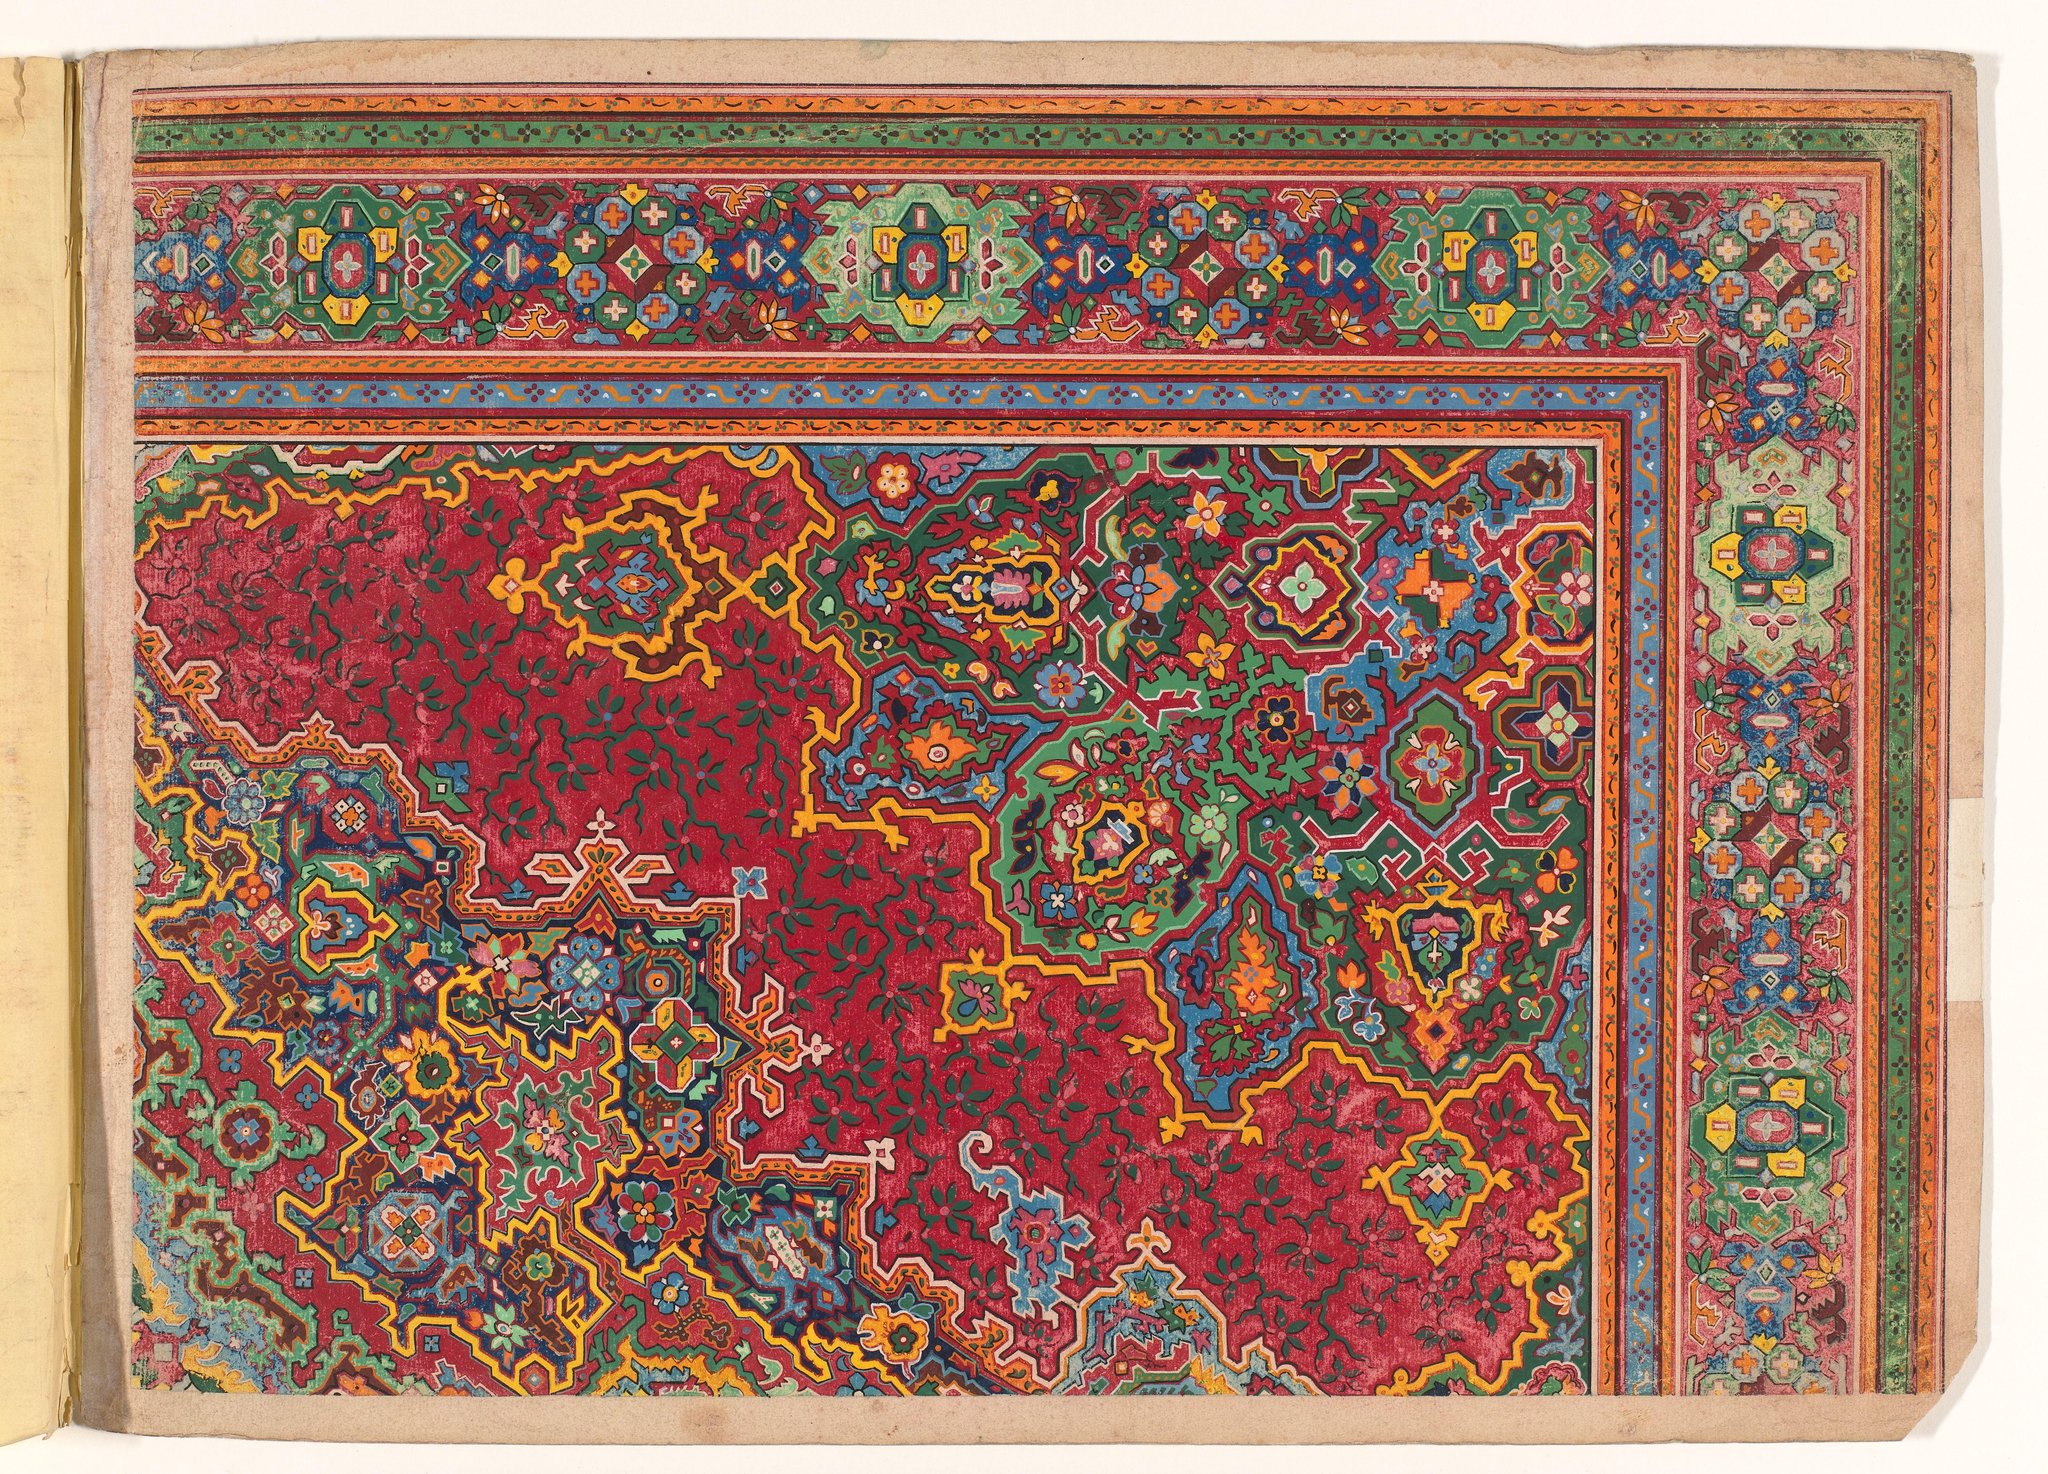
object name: design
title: Ontwerp voor een tapijt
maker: Anonymous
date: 1854-1864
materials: gouache, paper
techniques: brush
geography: deventer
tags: ornaments ~ art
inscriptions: inscription: ‘T’, retailer's mark: ‘JHS.’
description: De presentatietekeningen BK-1971-77-1 t/m 86 zijn kopieën van de originele ontwerptekeningen. Ze werden gemaakt voor vertegenwoordigers van bijvoorbeeld magazijnen, die ze aan hun klanten konden tonen. De meeste tekeningen tonen een kwart van het dessin inclusief rand, middenpartij (de zogenaamde grond of fond) en centraal medaillon. Door het gebruik van spiegels kan de illusie van het gehele tapijt worden opgeroepen. Een deel van de tekeningen heeft een alfabetische opeenvolgende letter als kenmerk, de andere groep een cijfer.Waarschijnlijk is de reeks dessins met een letter eerder samengesteld dan de genummerde tekeningen.